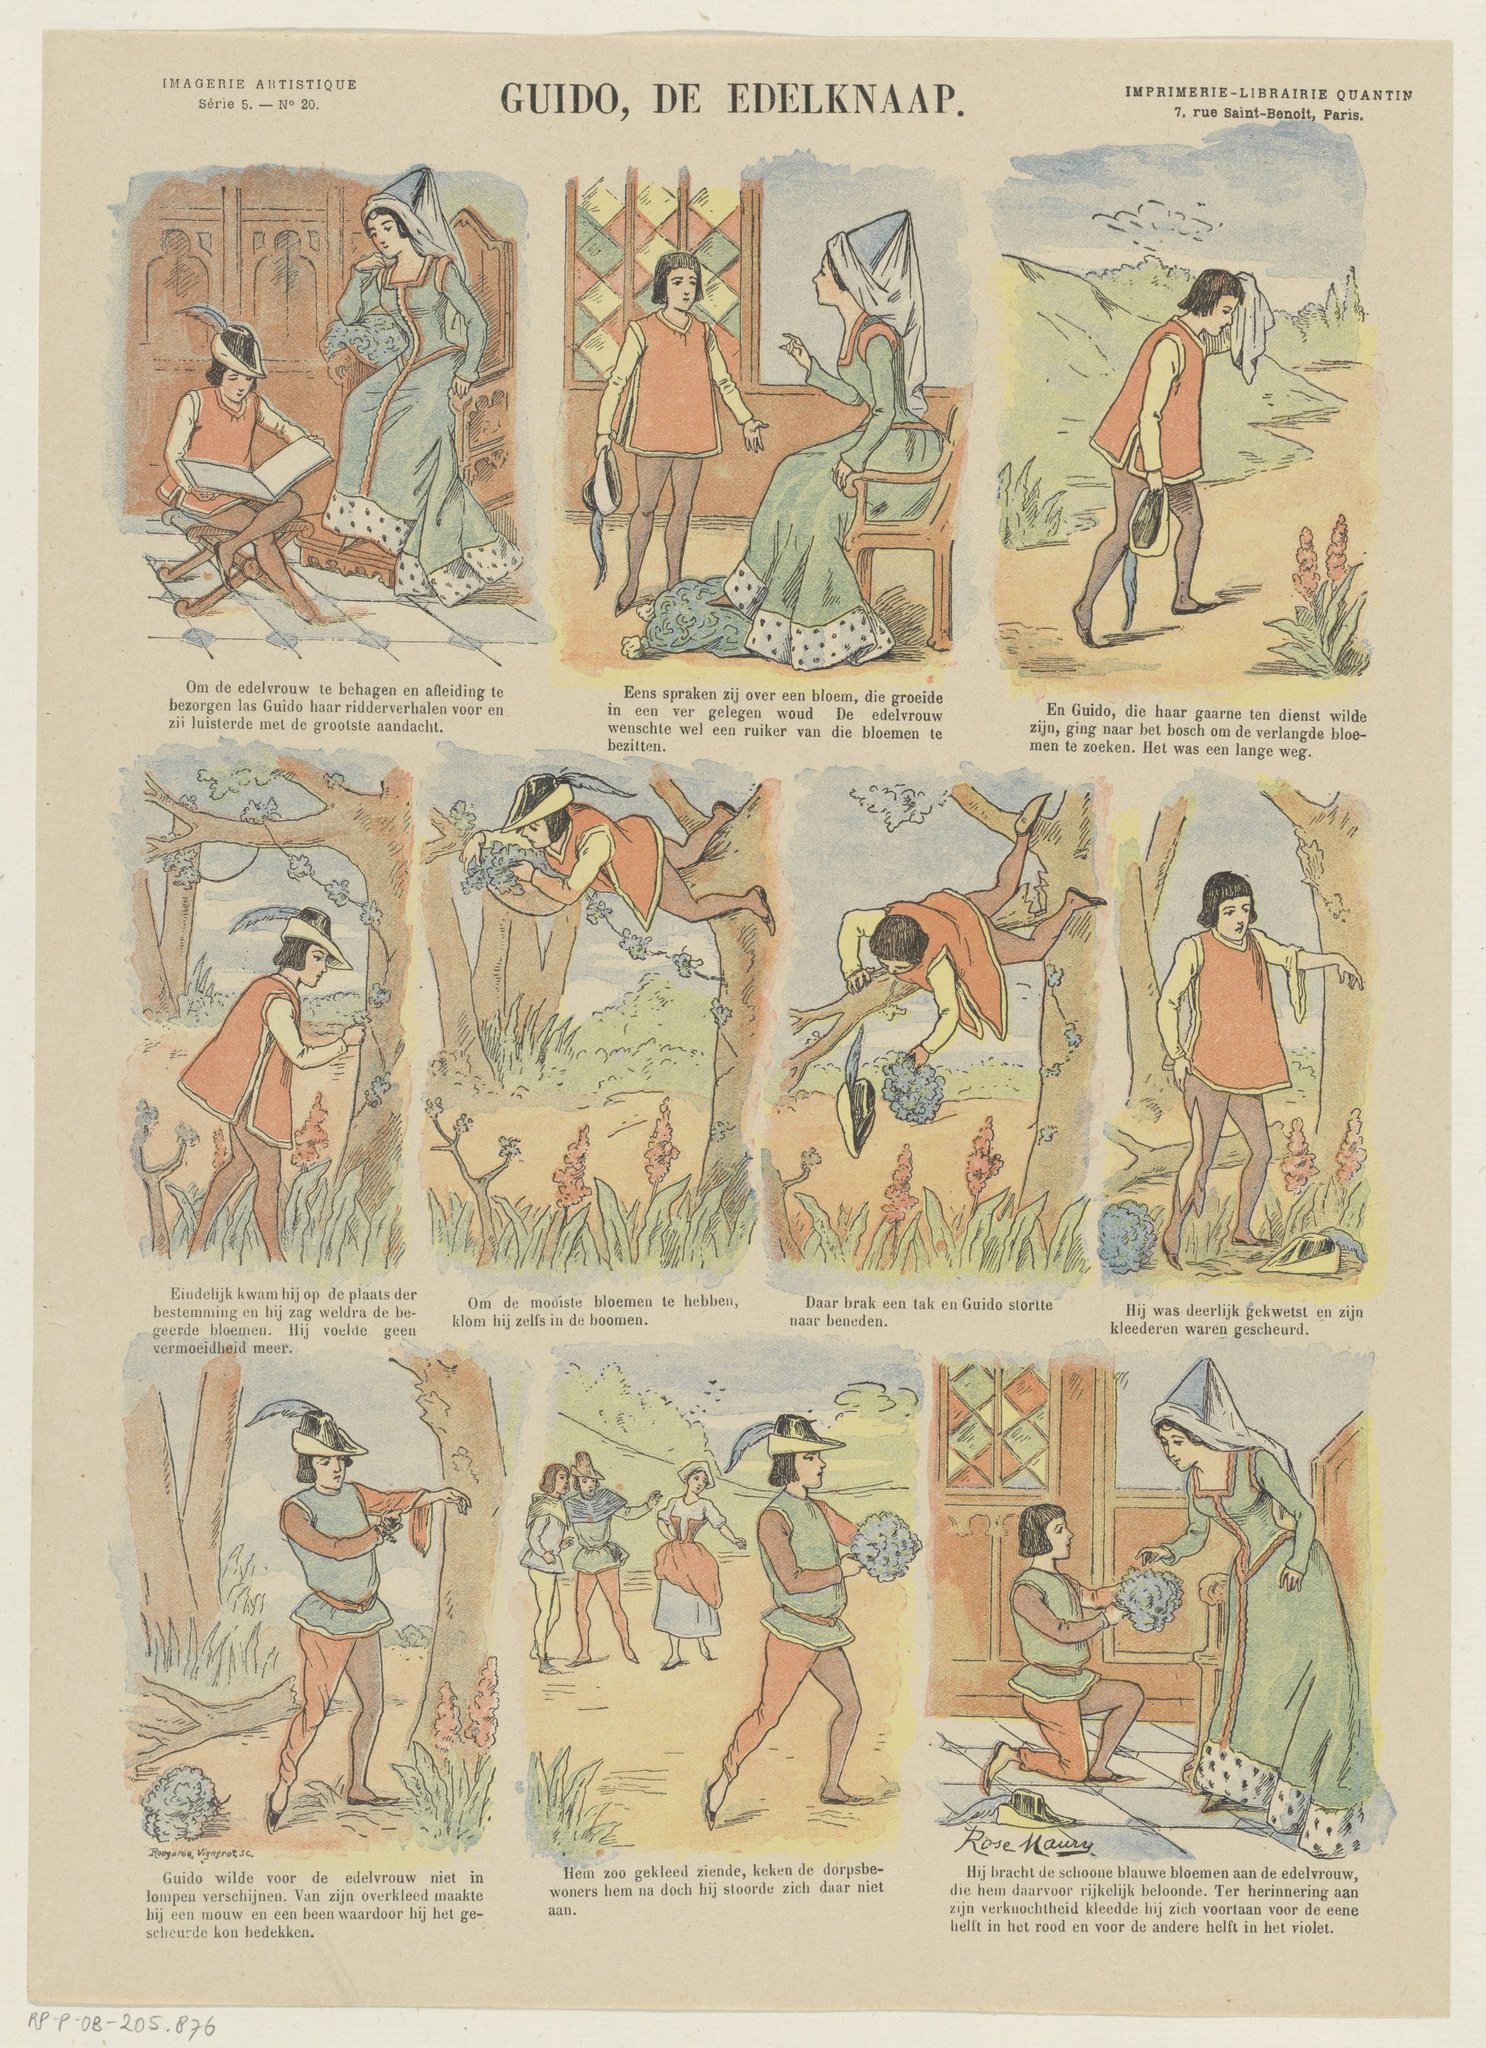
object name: print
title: Imagerie Artistique / Série 5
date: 1876-1890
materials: paper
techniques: lithograph, letterpress printing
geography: paris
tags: picking flowers, tales and fairy tales, nobility and patriciate; chivalry, knighthood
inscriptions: collector's mark: Lugt 2760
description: Blad met 10 voorstellingen uit het verhaal van Guido de edelknaap die tijdens het bloemenplukken valt en zijn kleren vernielt. Onder elke voorstelling een onderschrift. Genummerd linksboven: Série 5. - No. 20.